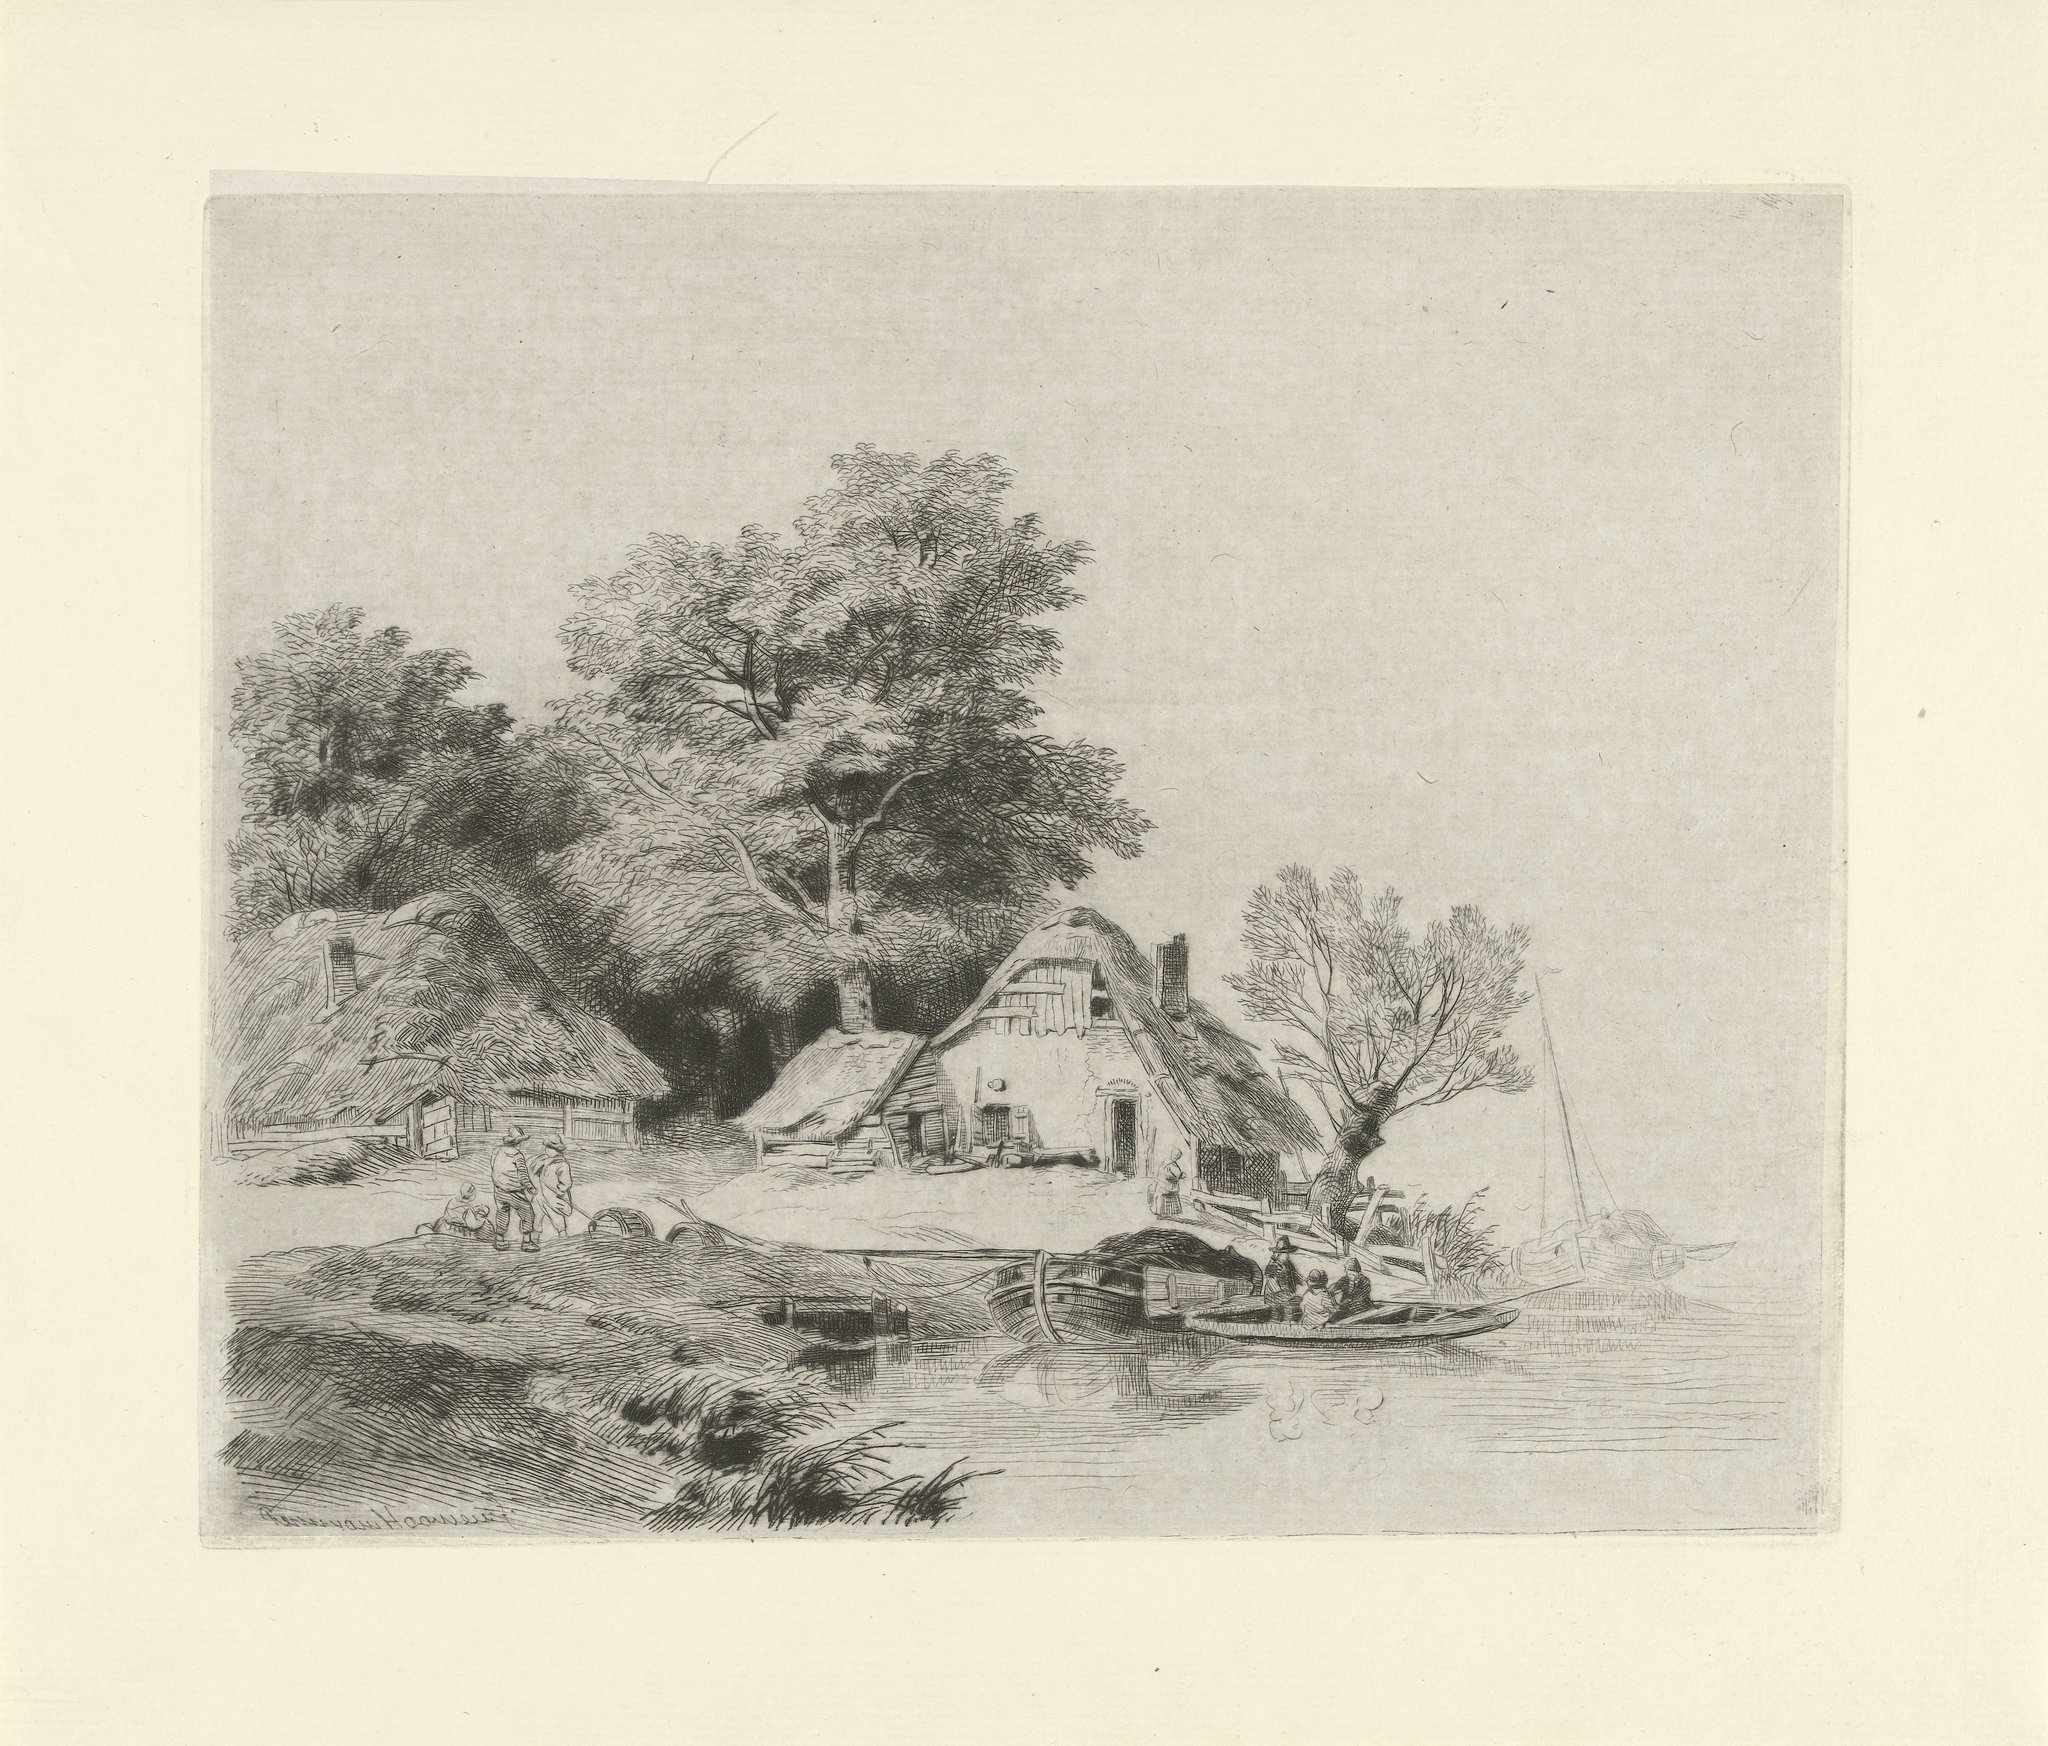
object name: print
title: Boerderij aan het water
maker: remigius adrianus haanen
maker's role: draughtsman, painter, print maker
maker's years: 1812-1894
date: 1827-1879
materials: paper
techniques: drypoint, etching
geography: austria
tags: farm or solitary house in landscape (+ city(-scape) with figures, staffage)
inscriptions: collector's mark: Lugt 2228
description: Een boerderij naast een bomenrij aan het water, twee boten aan de oever.